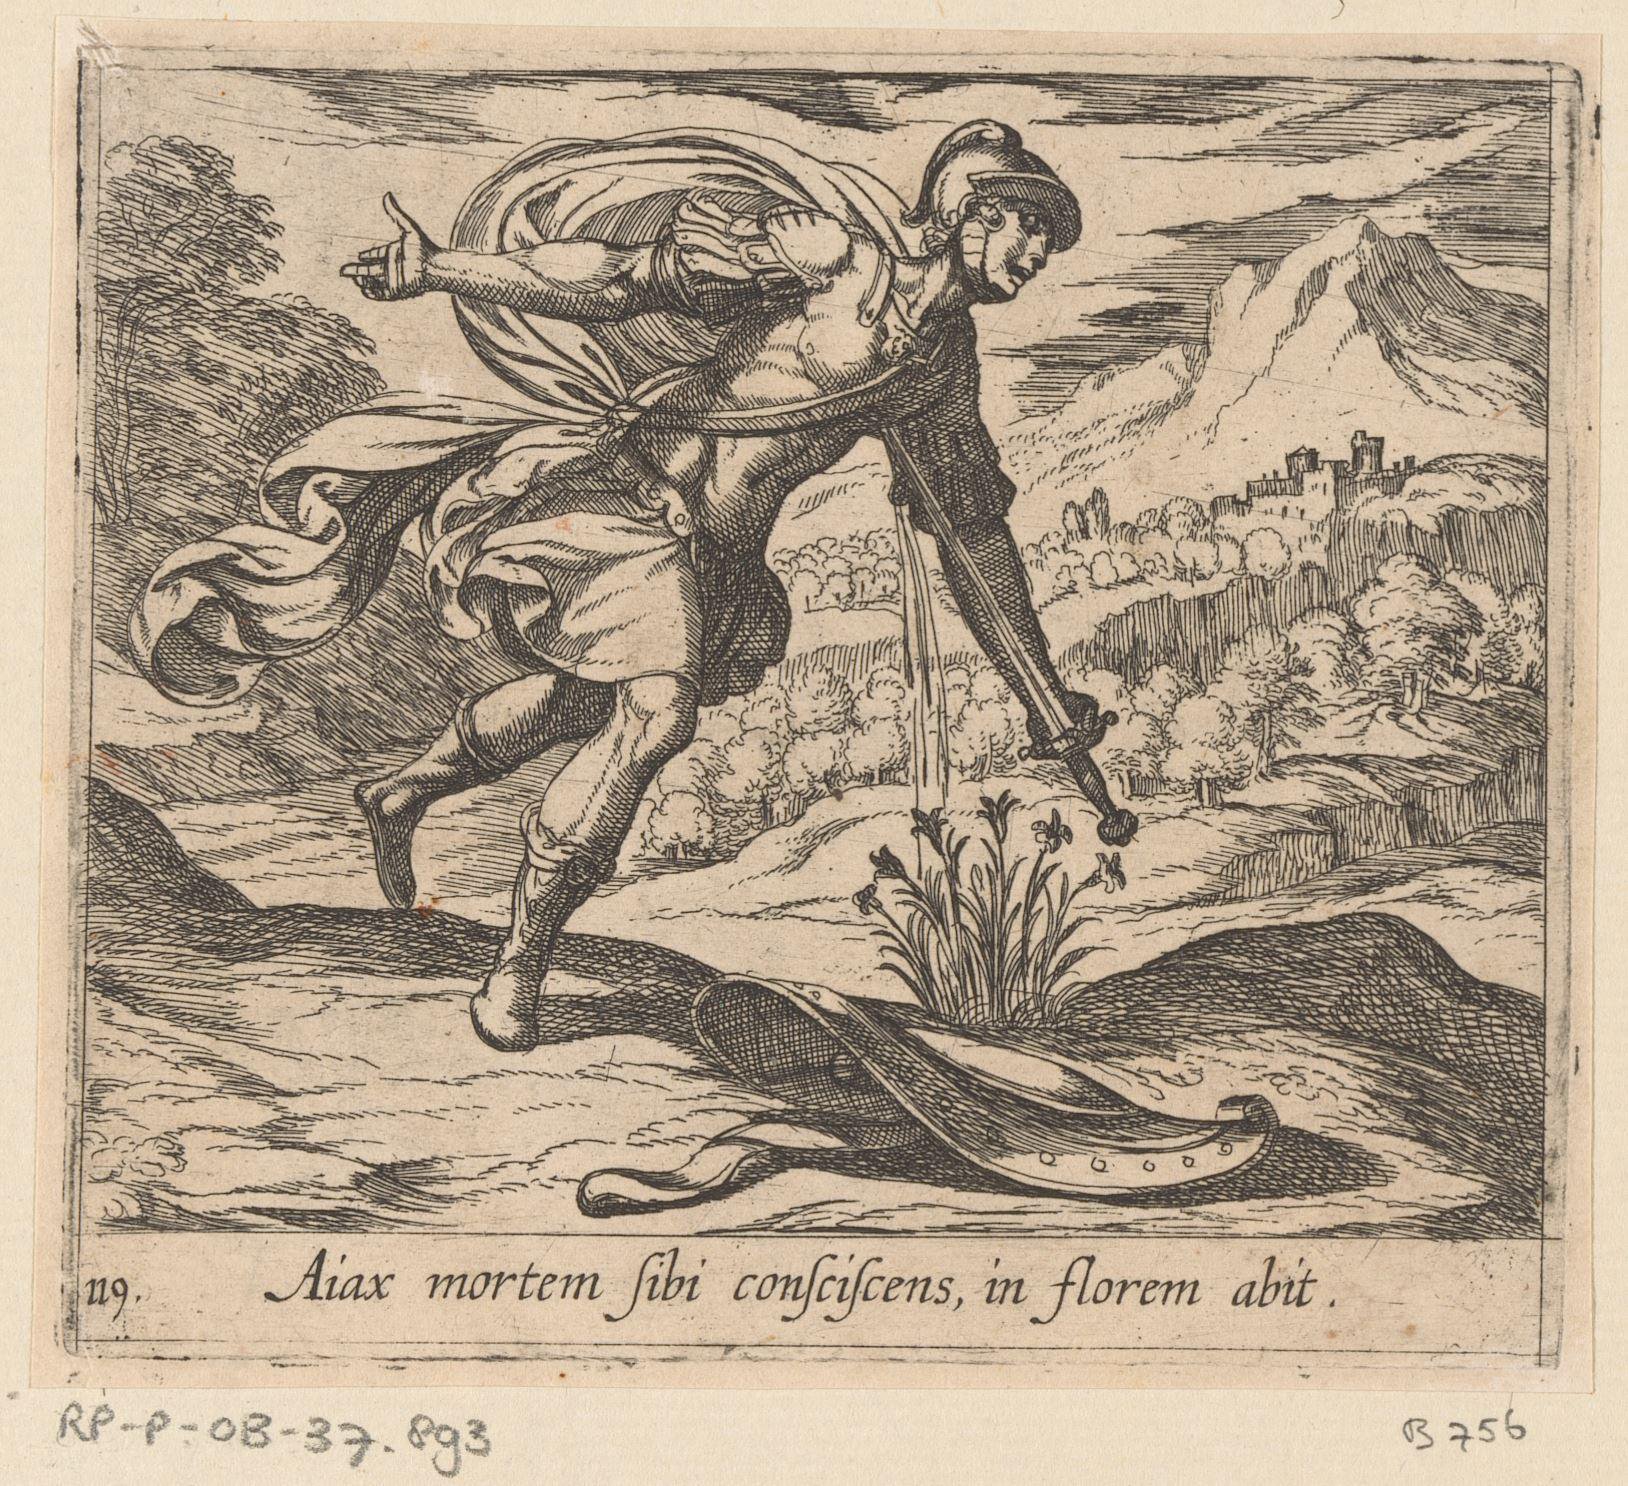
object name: print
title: Metamorfosen van Ovidius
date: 1606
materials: paper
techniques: etching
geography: italy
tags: ajax' blood changed into a hyacinth: after ajax has taken his own life, his blood is changed into a hyacinth (ovid, metamorphoses x 207; xiii 390), suicide of ajax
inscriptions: collector's mark: Lugt 240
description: Ajax stort zich in zijn eigen zwaard, nadat hij de strijd om de wapenrusting van Achilles verloren heeft. Titel in het Latijn in ondermarge.